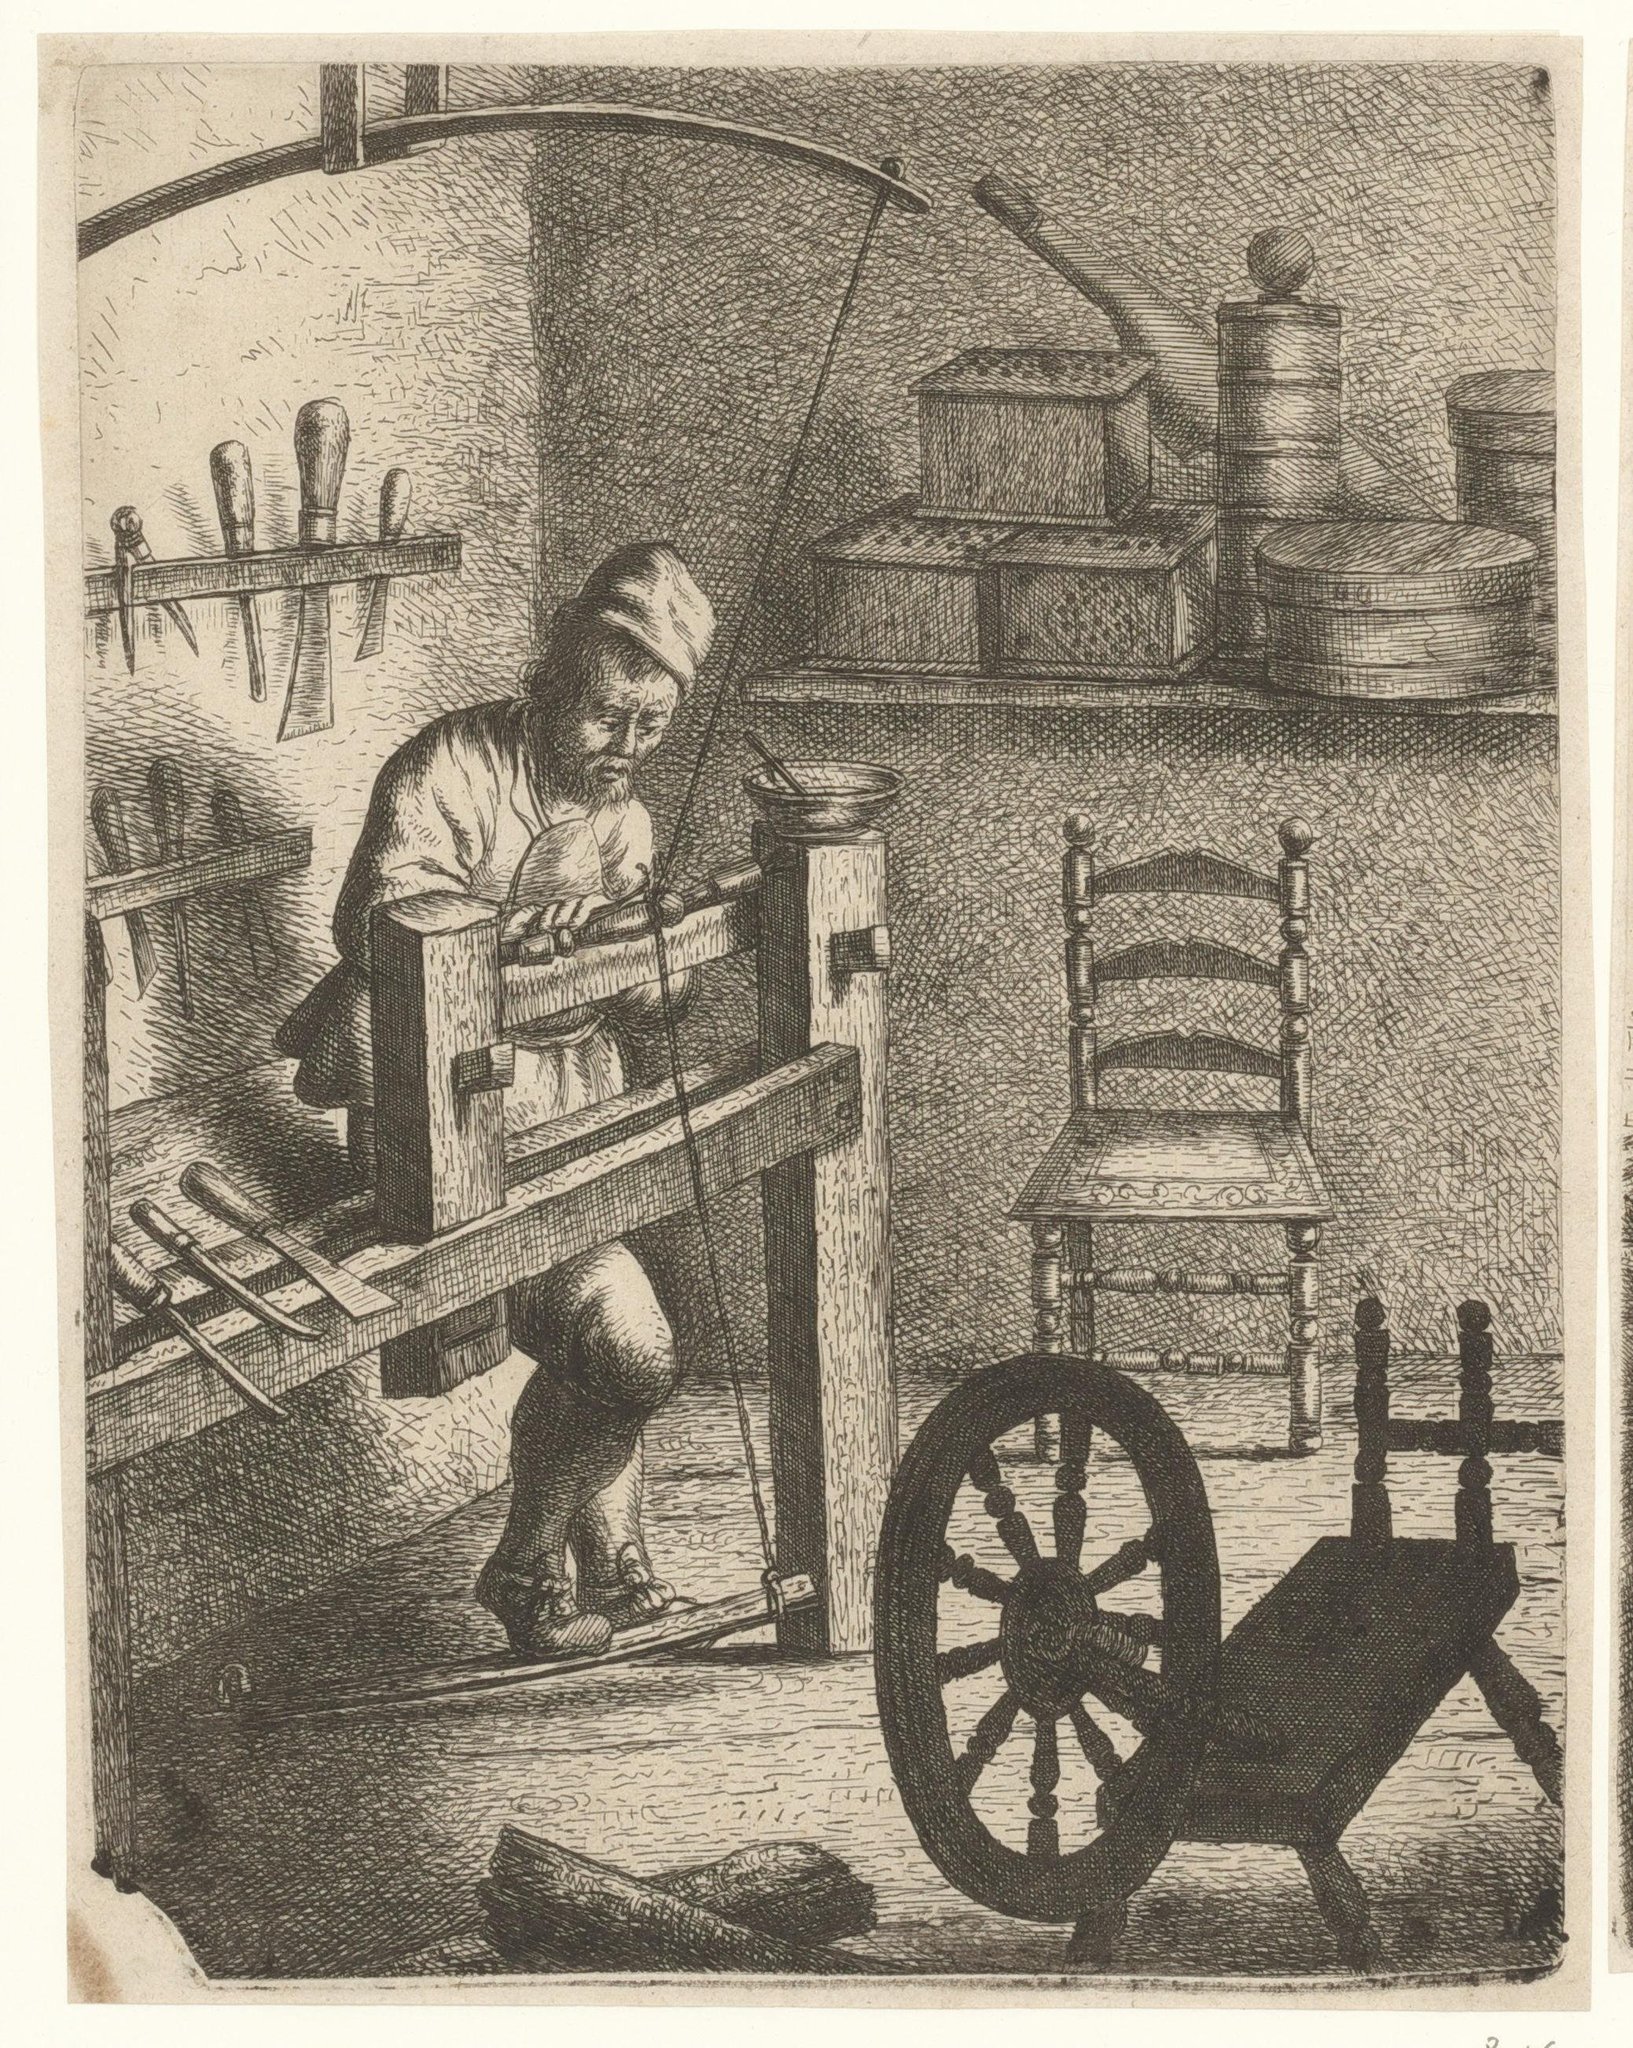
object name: print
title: Werker achter een draaibank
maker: jan gillisz. van vliet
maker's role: draughtsman, painter, print maker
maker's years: 1600-1668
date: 1635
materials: paper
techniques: etching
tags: turner in wood, tools, aids, implements ~ crafts and industries: chisel, spinning-wheel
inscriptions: stamp, collector's mark: Lugt 1641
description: Een man achter een draaibank. Aan de achterwand beitels. Op de voorgrond een spinnewiel. Onderwerpsrubrieken binnen de Atlas Zeden en Gewoonten: Handel, Nijverheid en Verkeer, Beroep en bedrijf, Complete suites.